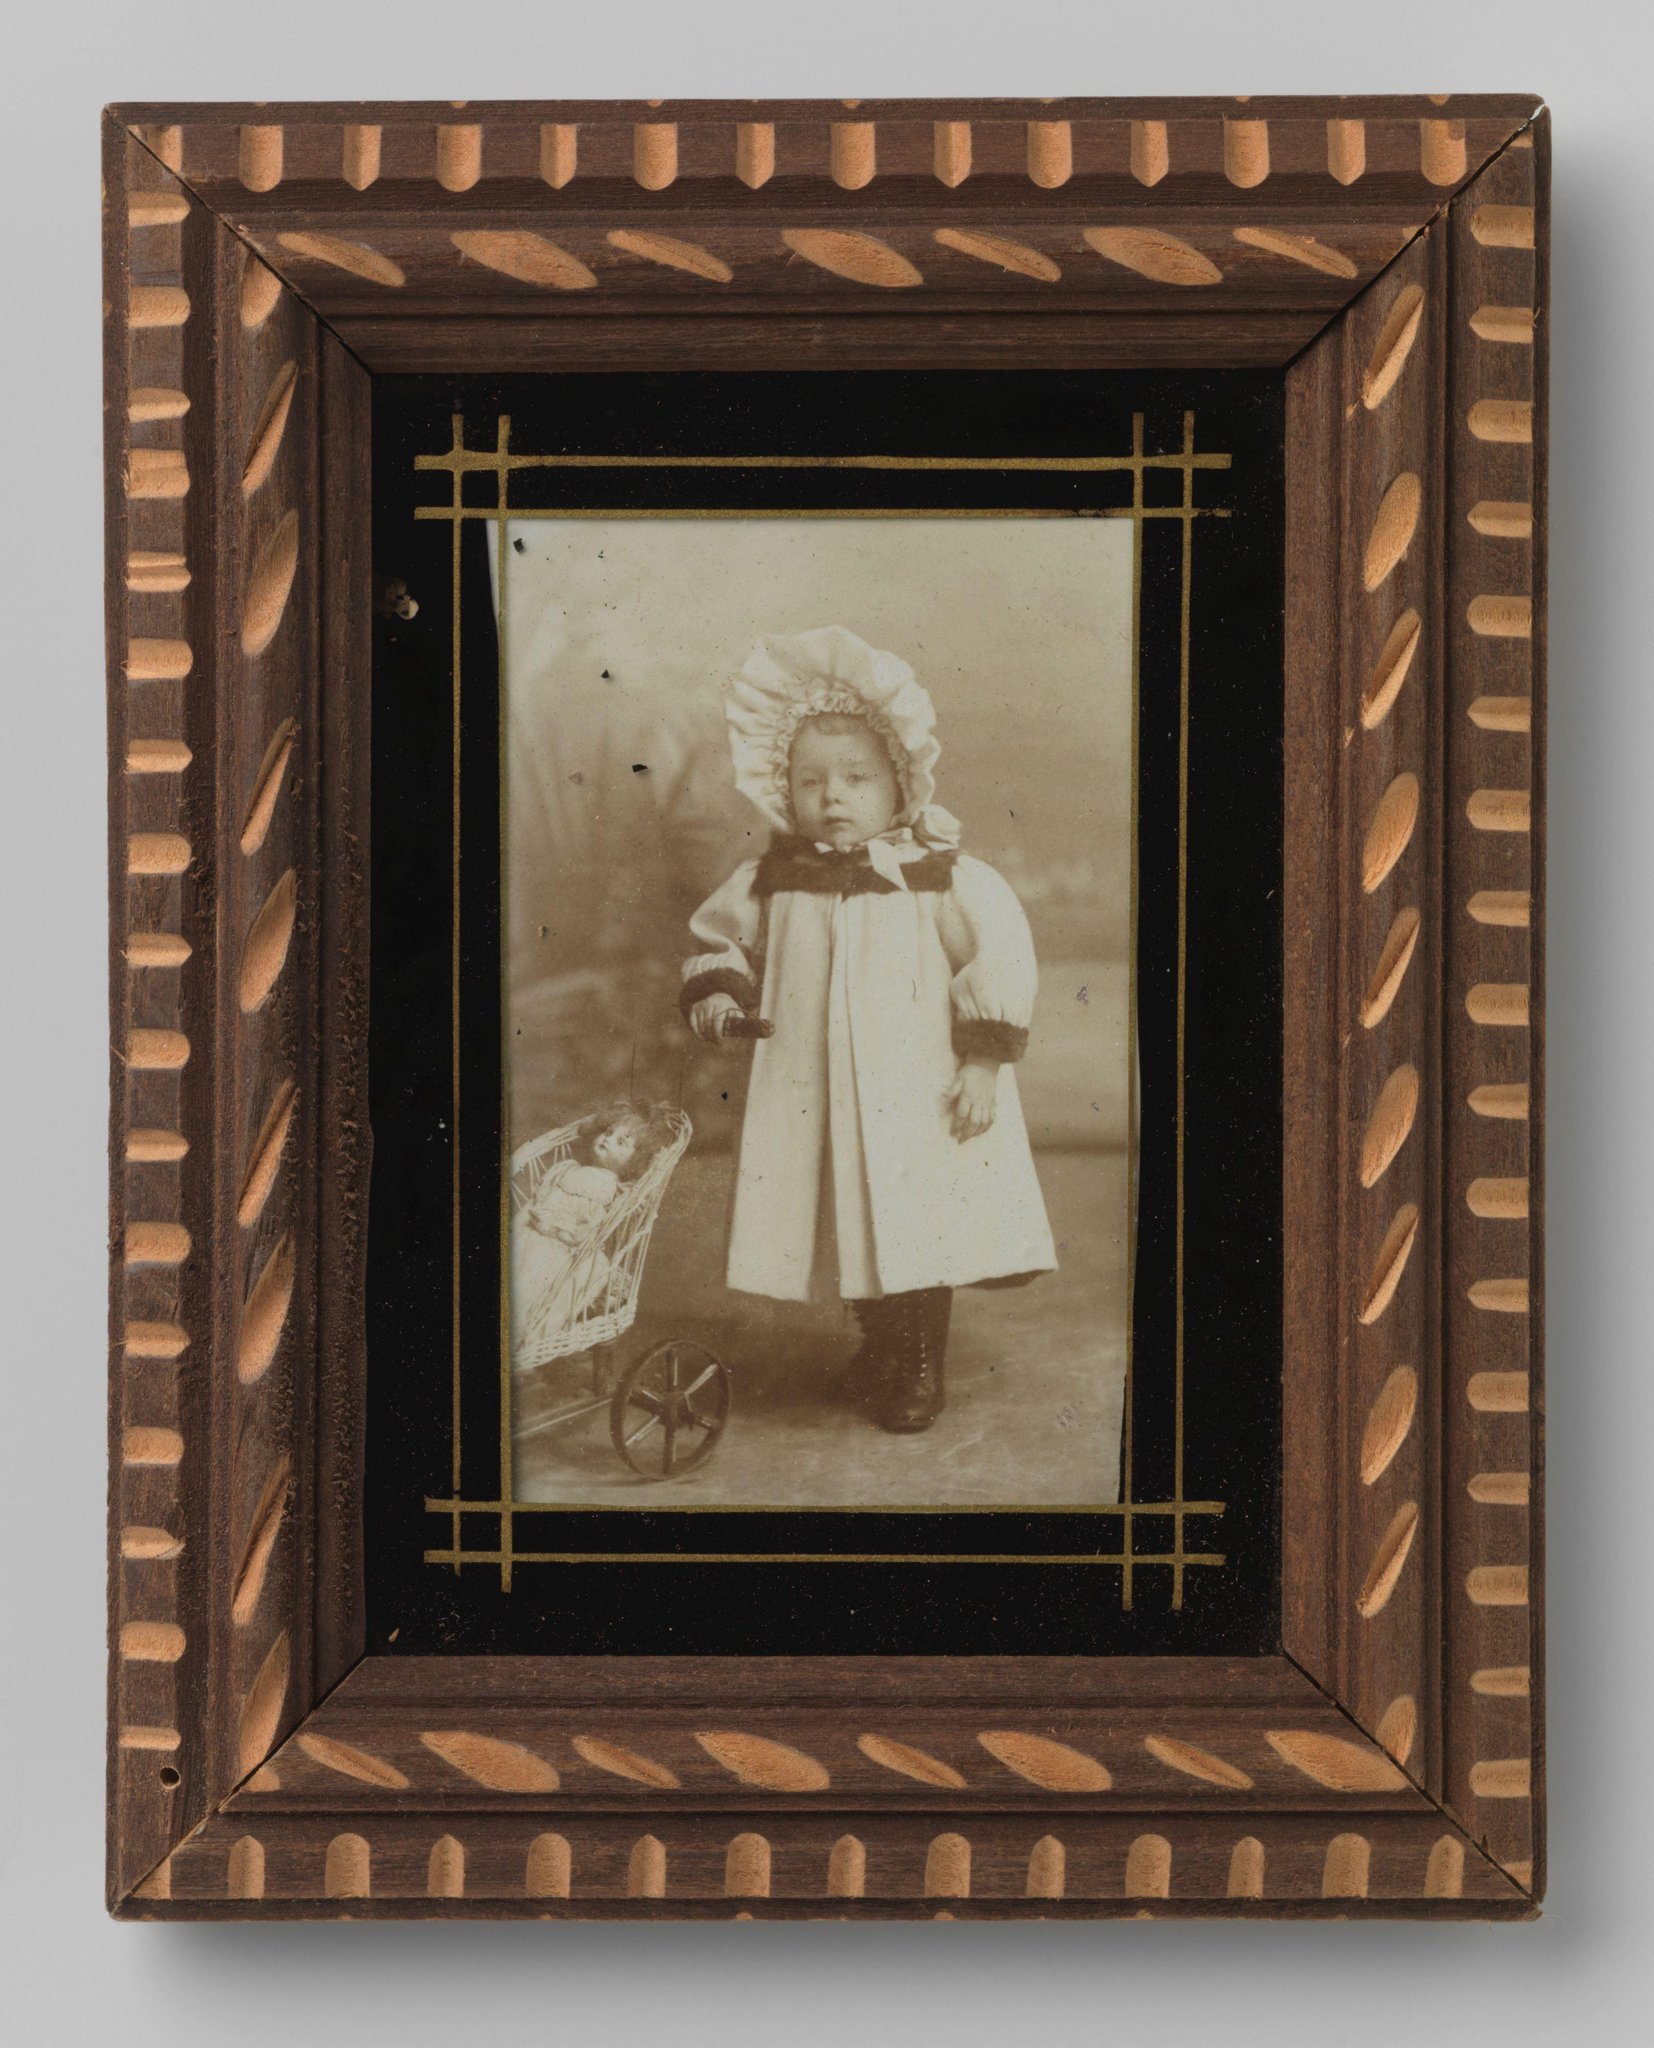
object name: photograph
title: Portret van een onbekend meisje met poppenwagen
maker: Anonymous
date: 1880-1900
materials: paper, glass, wood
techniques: gelatin silver print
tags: anonymous historical person portrayed alone, (playing with) dolls, toddler - aa - girl